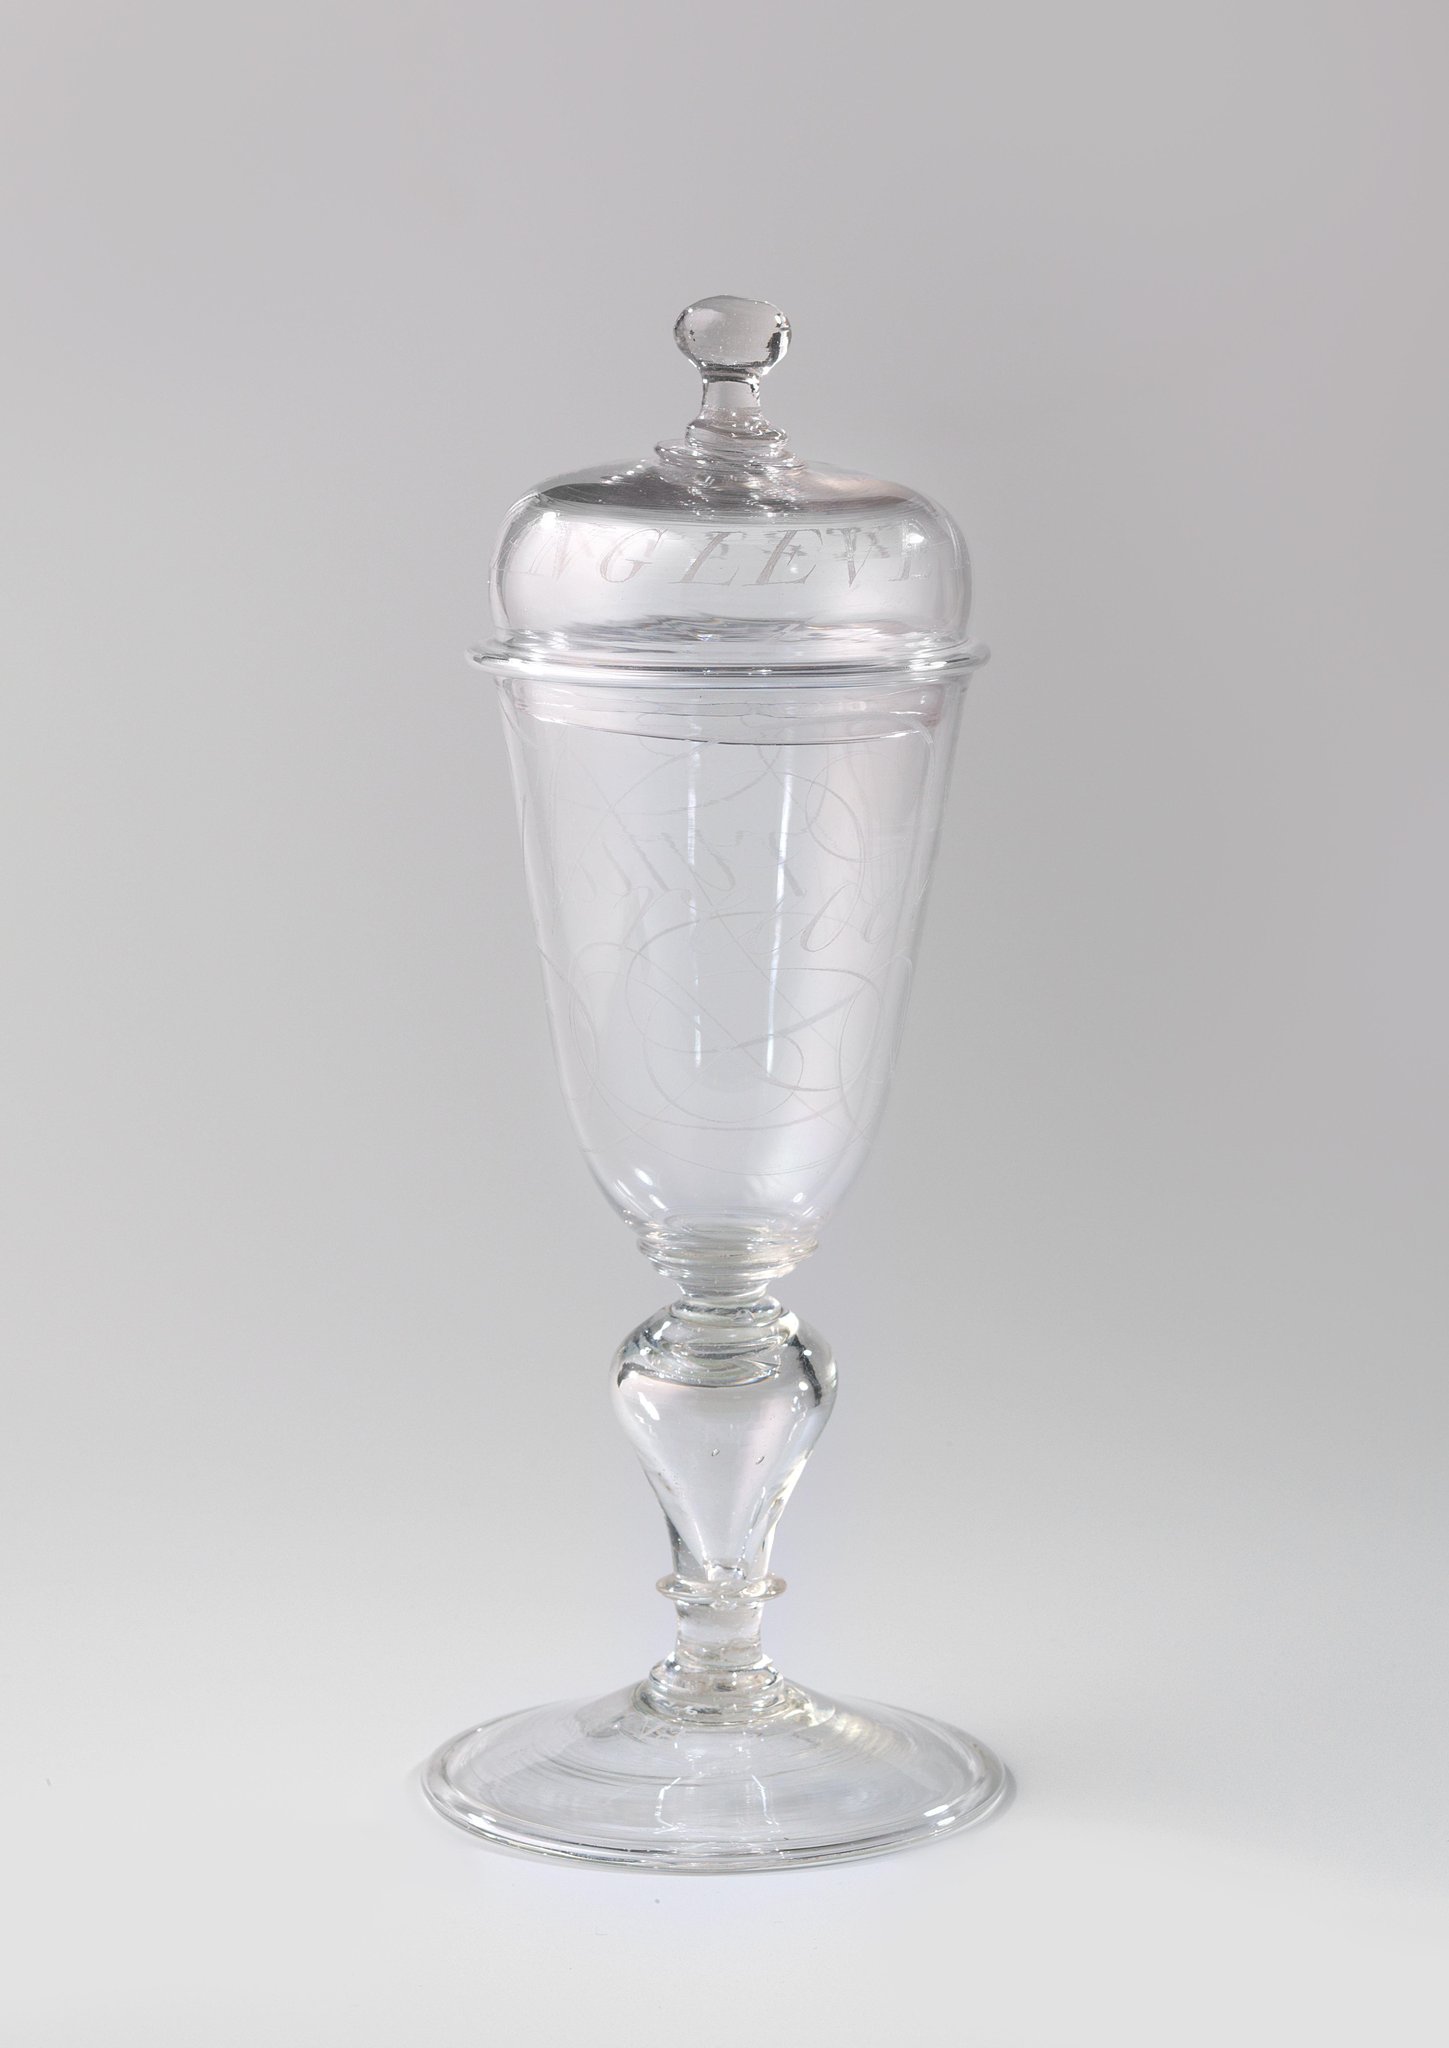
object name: lid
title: Deksel met het opschrift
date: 1670-1700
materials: glass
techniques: diamond point engraving, façon de venise, glassblowing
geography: low countries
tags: w. post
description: Op het deksel het gekalligrafeerd opschrift: Lang leve in Vreug'.